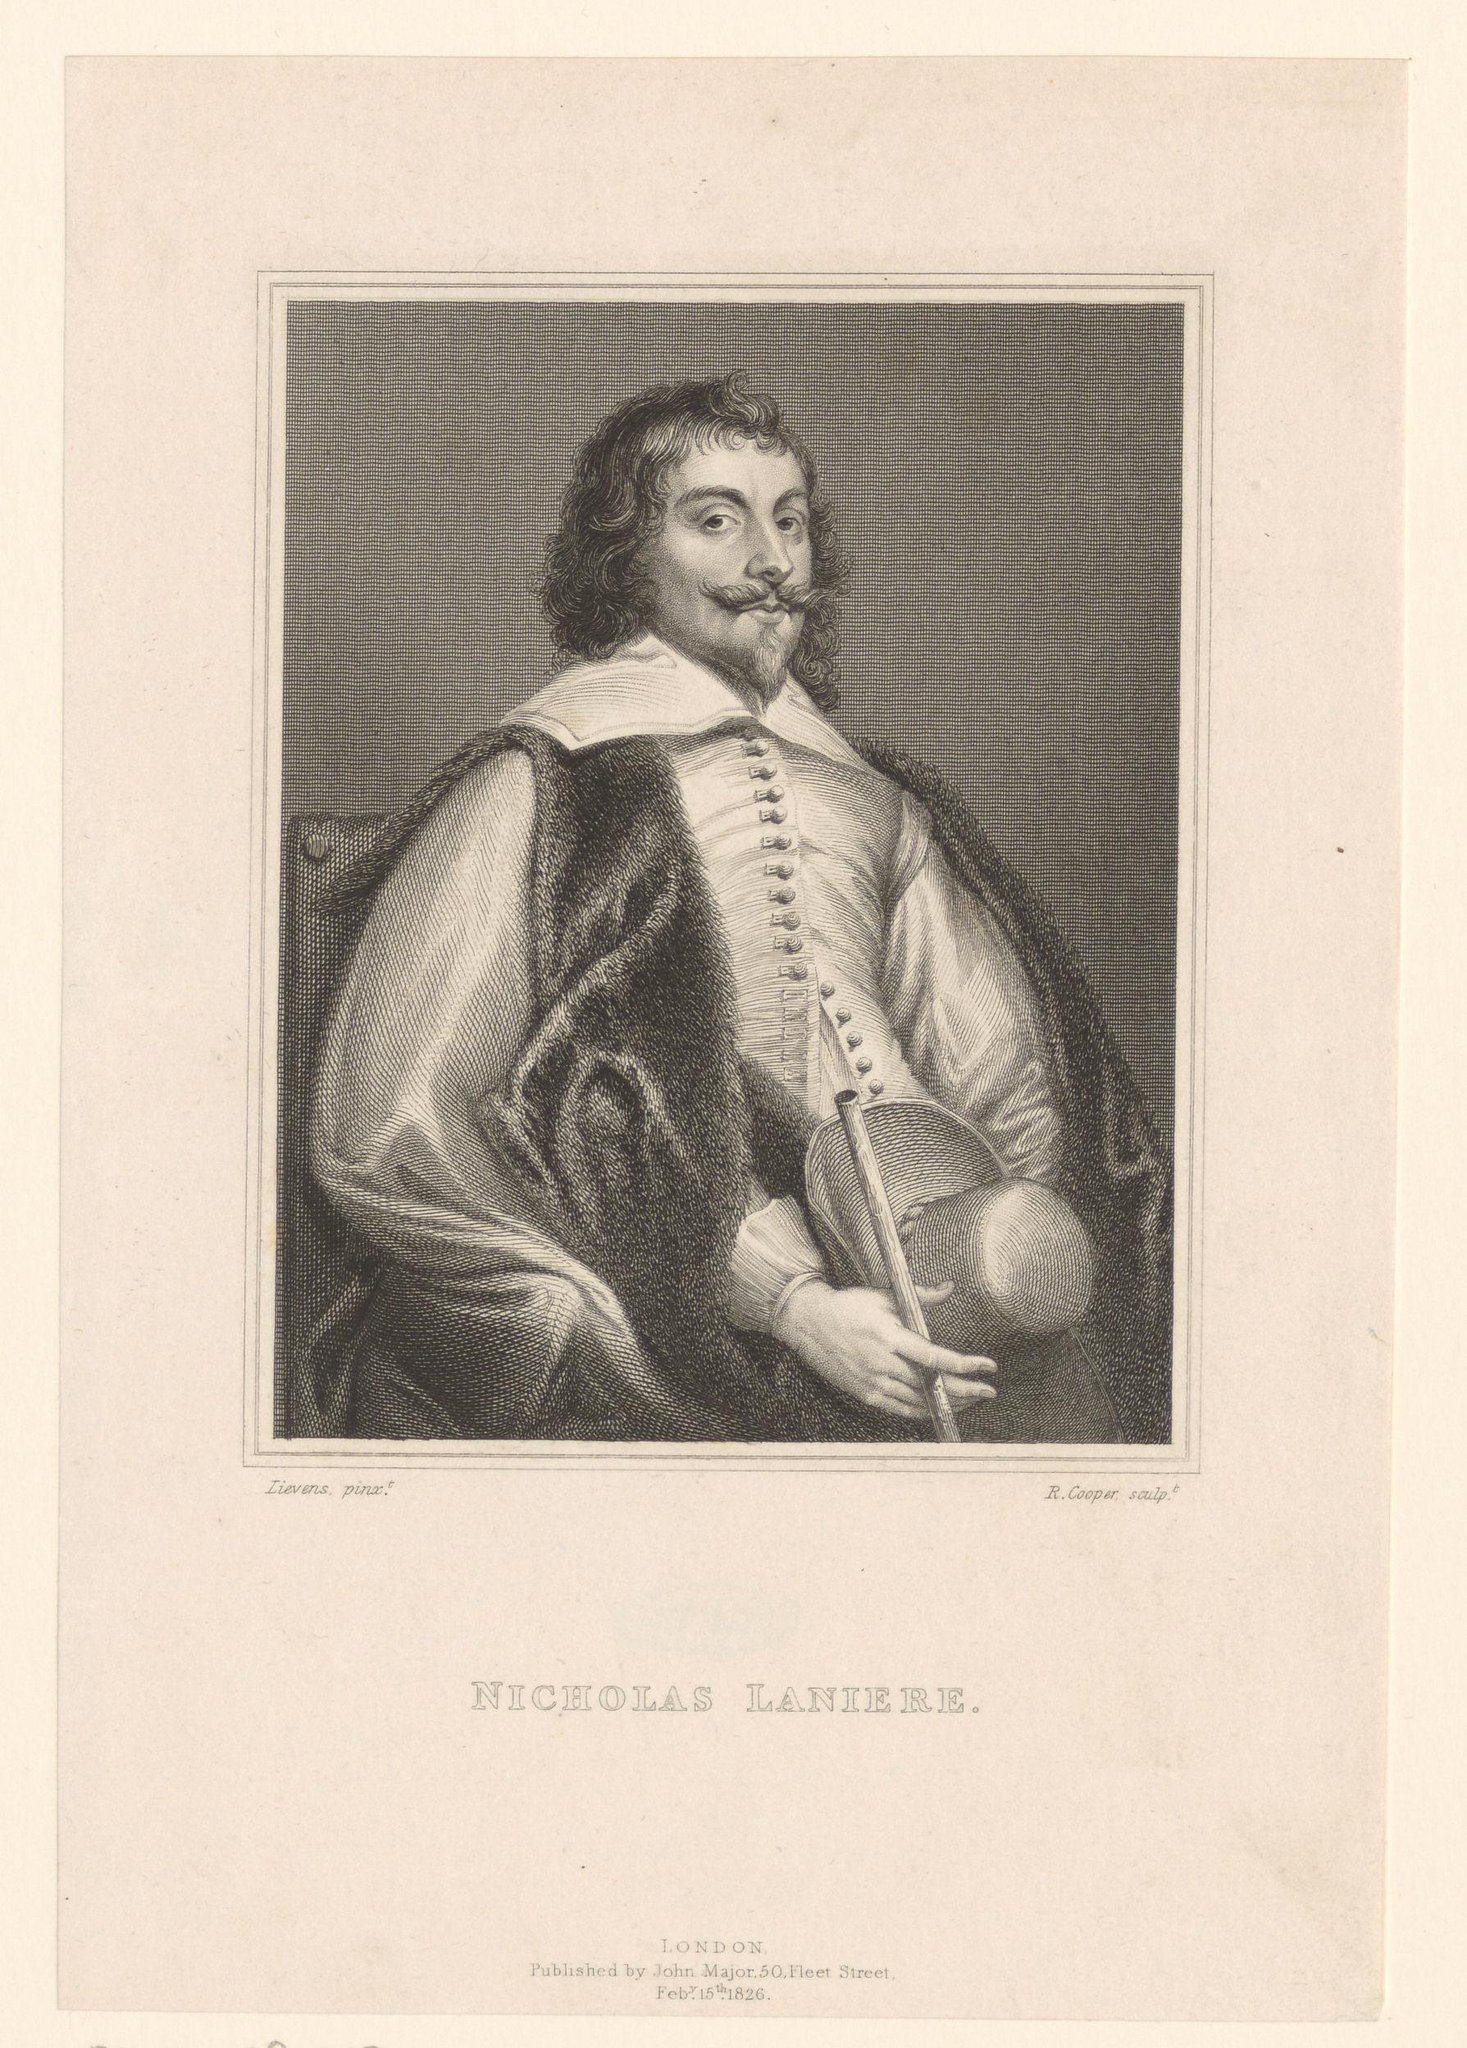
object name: print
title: Nicholas Laniere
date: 1826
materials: paper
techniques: etching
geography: london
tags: historical persons, portrait of a musician, portrait of composer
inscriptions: collector's mark: Lugt 2228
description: Prent uit: Vertue, George, en Horace Walpole. Anecdotes of Painting in England (...). Londen: John Major, 1826, dl. 2, p. 270.